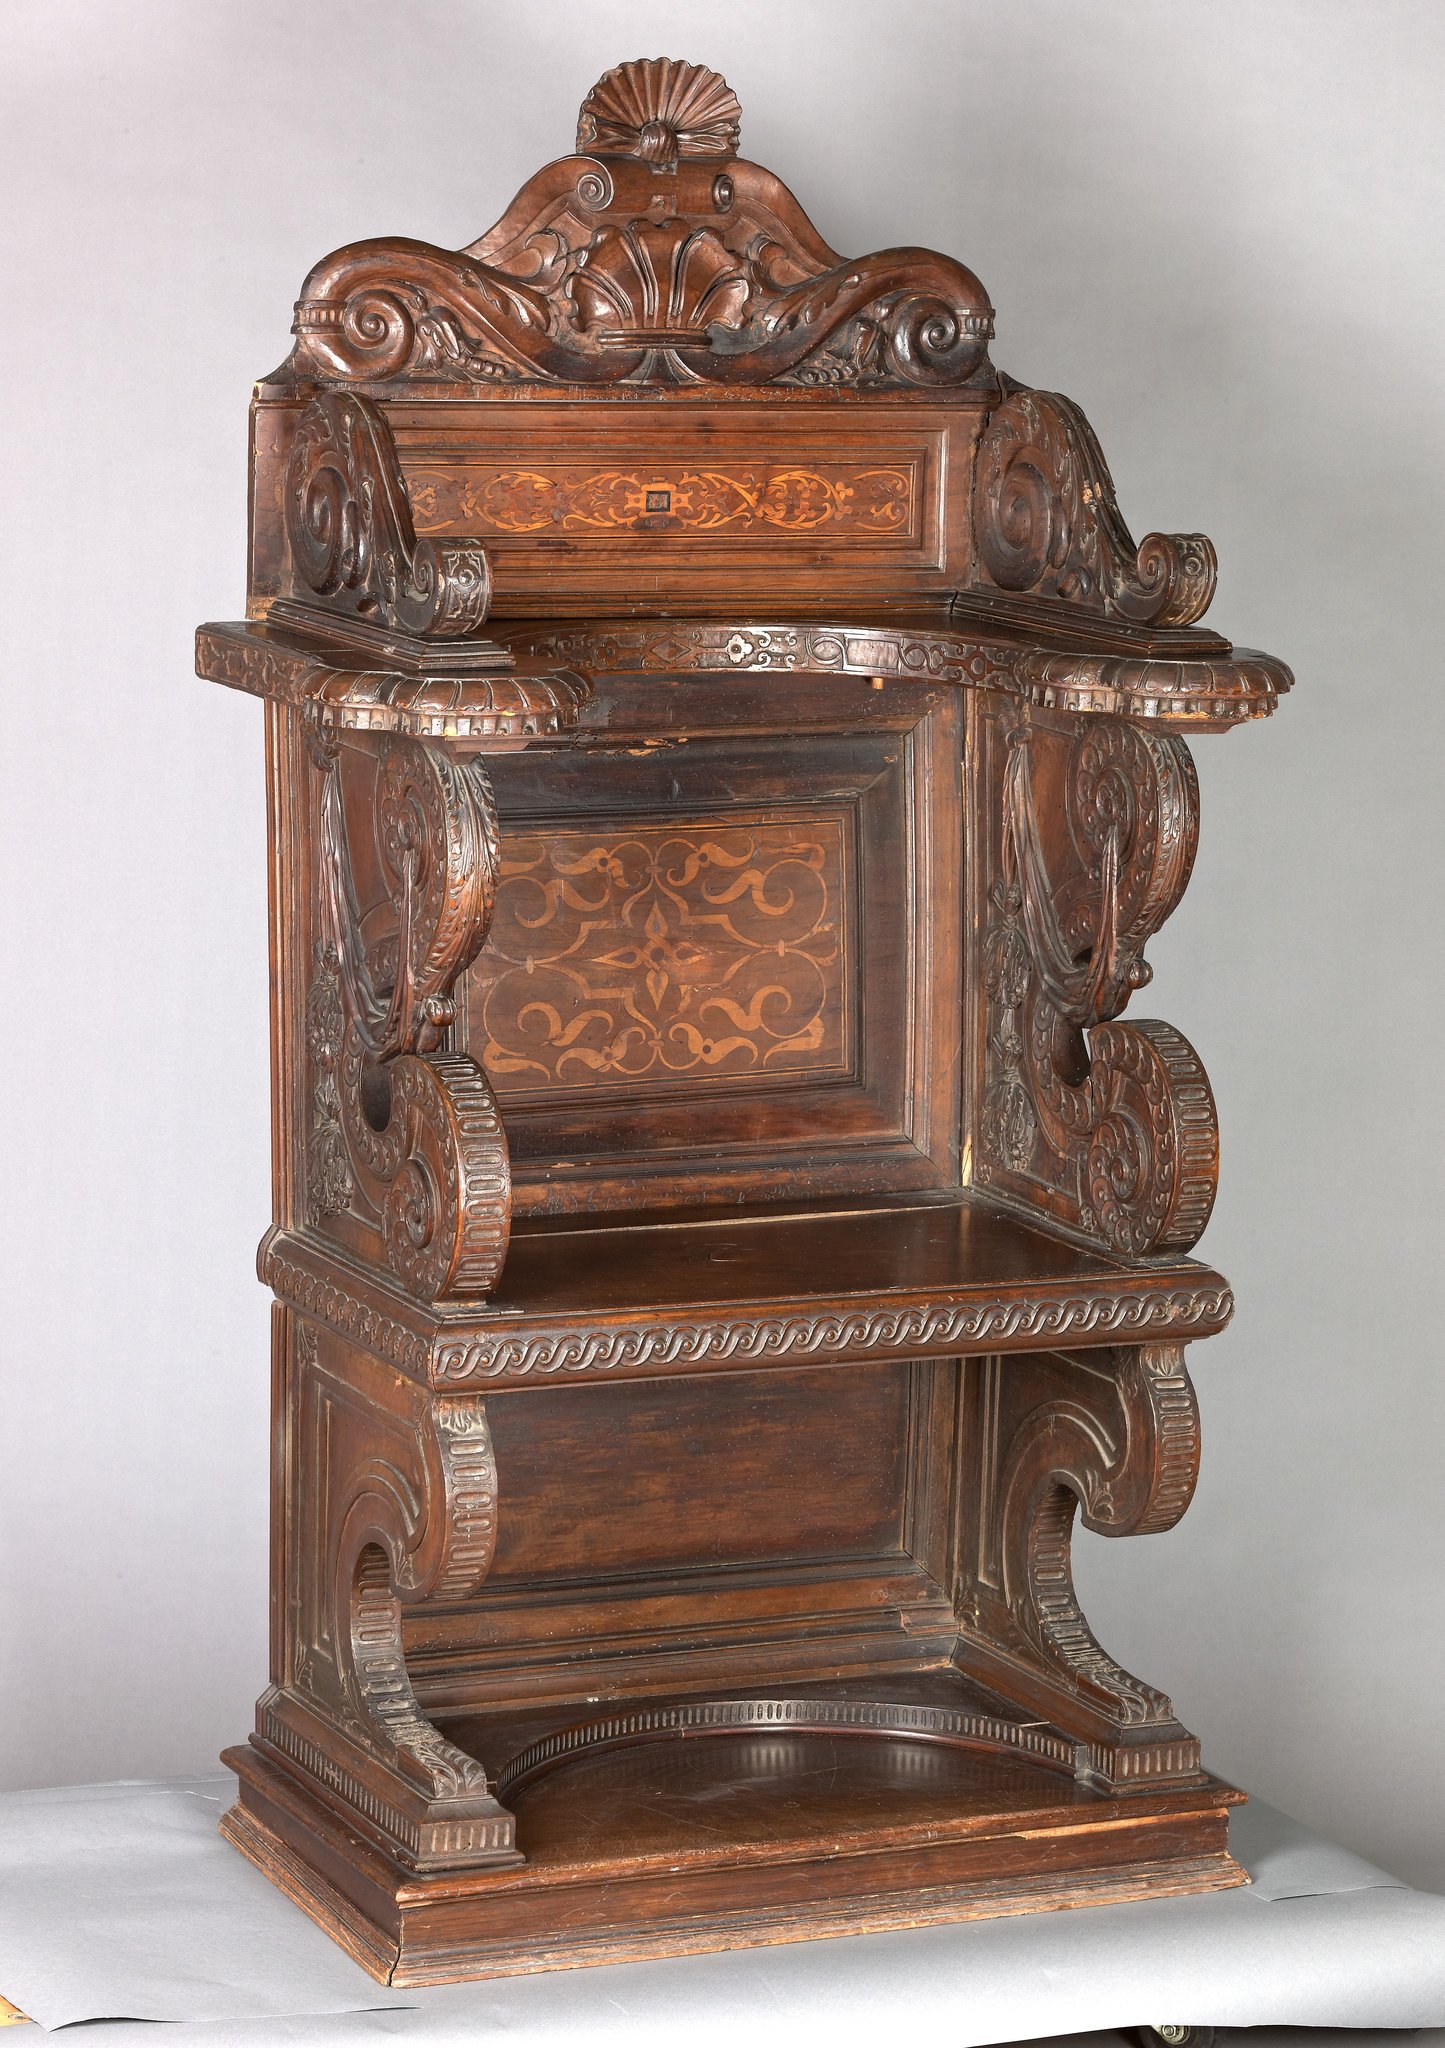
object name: chair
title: Choir chair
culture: italian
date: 1501-1533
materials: wood